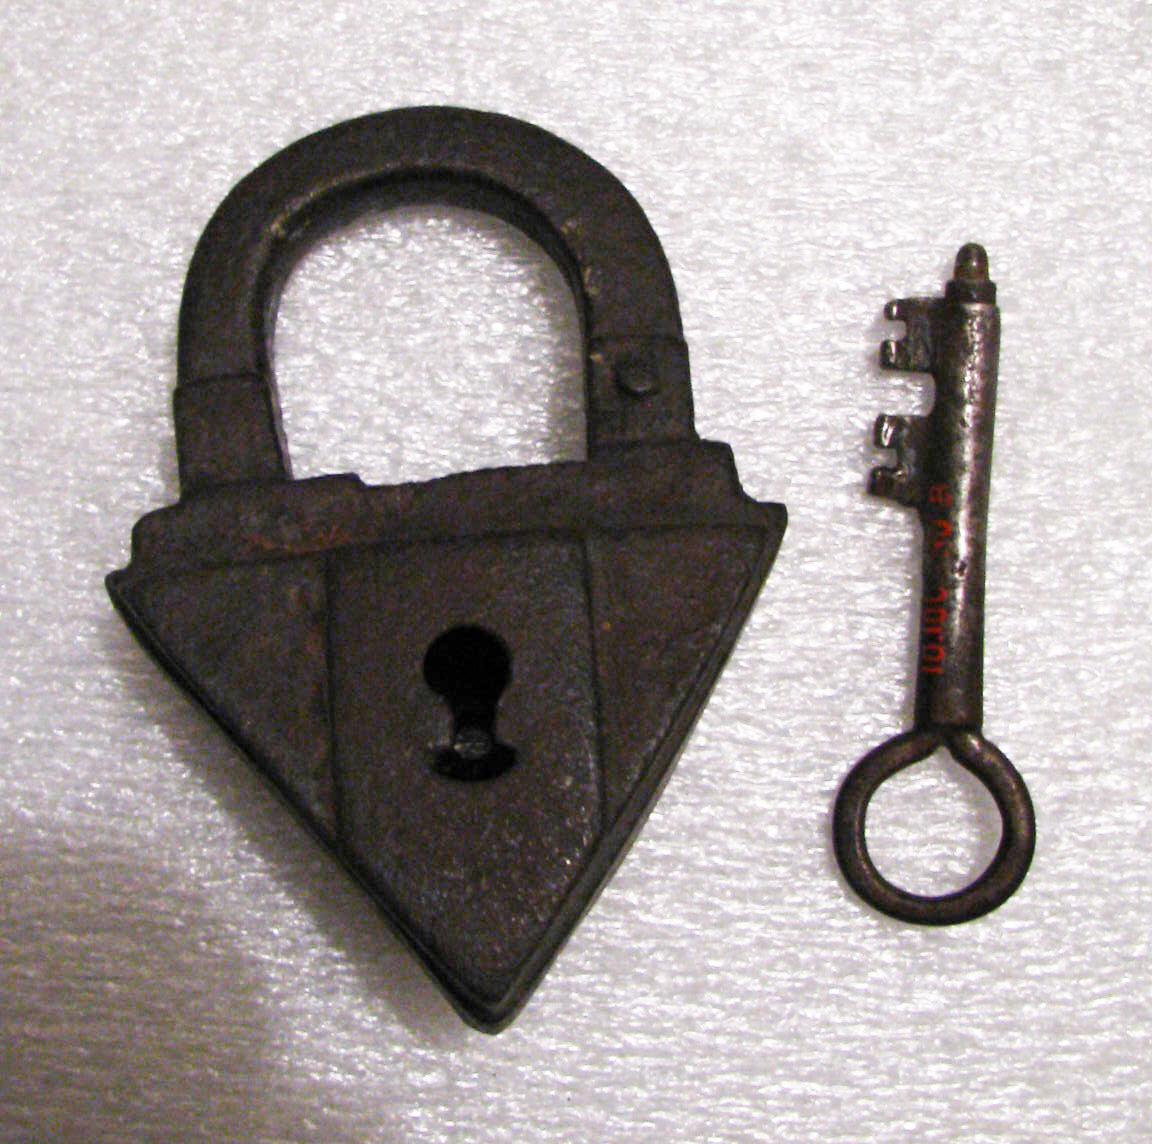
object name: padlock with key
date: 1601-1700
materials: iron